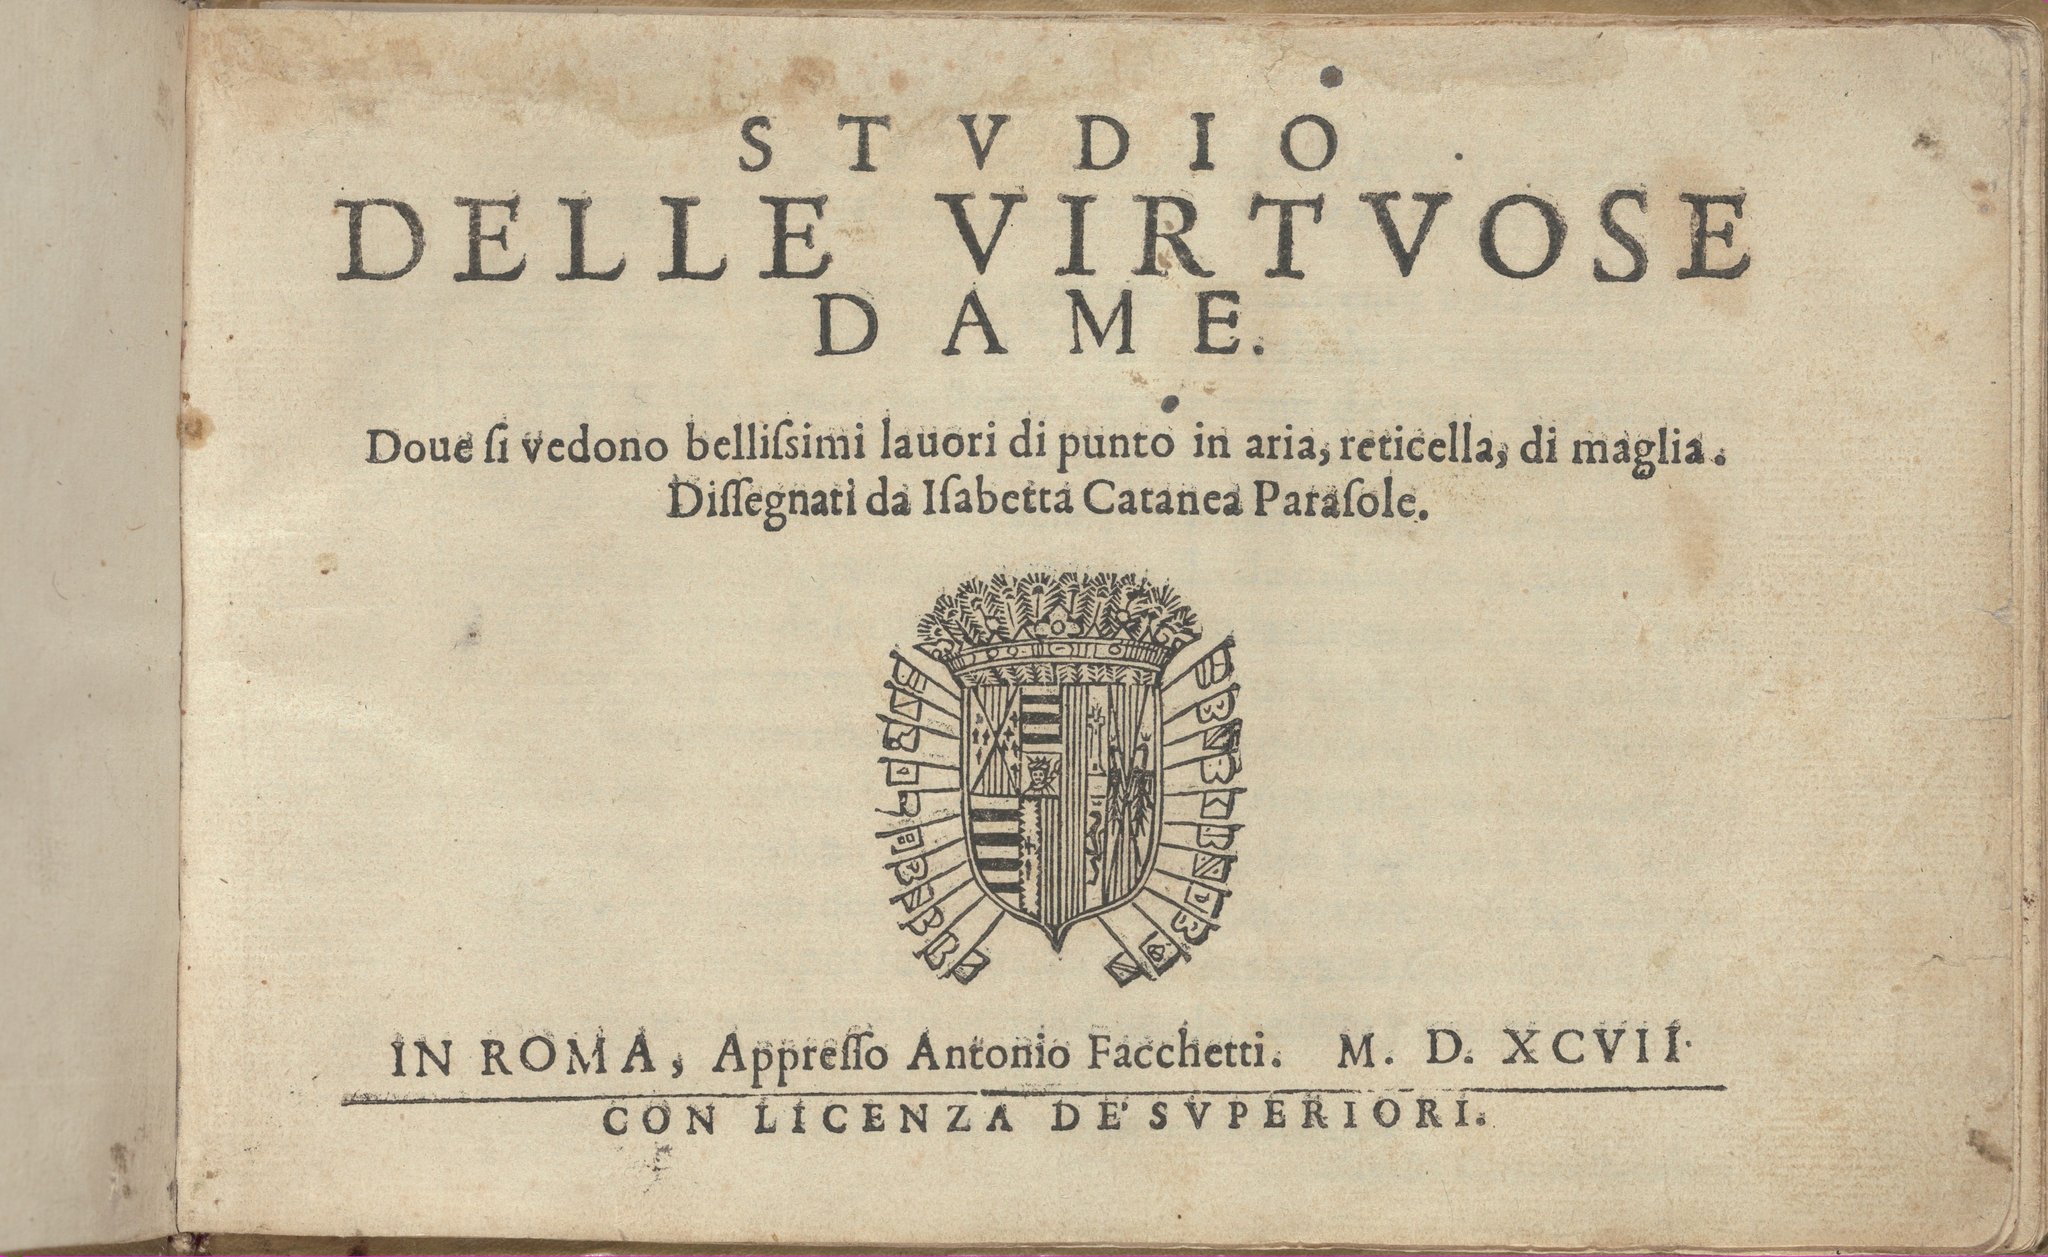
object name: book print ornament architecture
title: Studio delle virtuose Dame, title page (recto)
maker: isabella catanea parasole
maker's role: designer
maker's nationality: italian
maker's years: 1565-1625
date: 1597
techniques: woodcut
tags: coat of arms